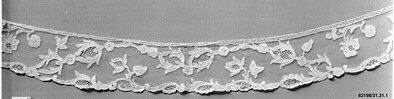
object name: edging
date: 1701-1800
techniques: lace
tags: flowers